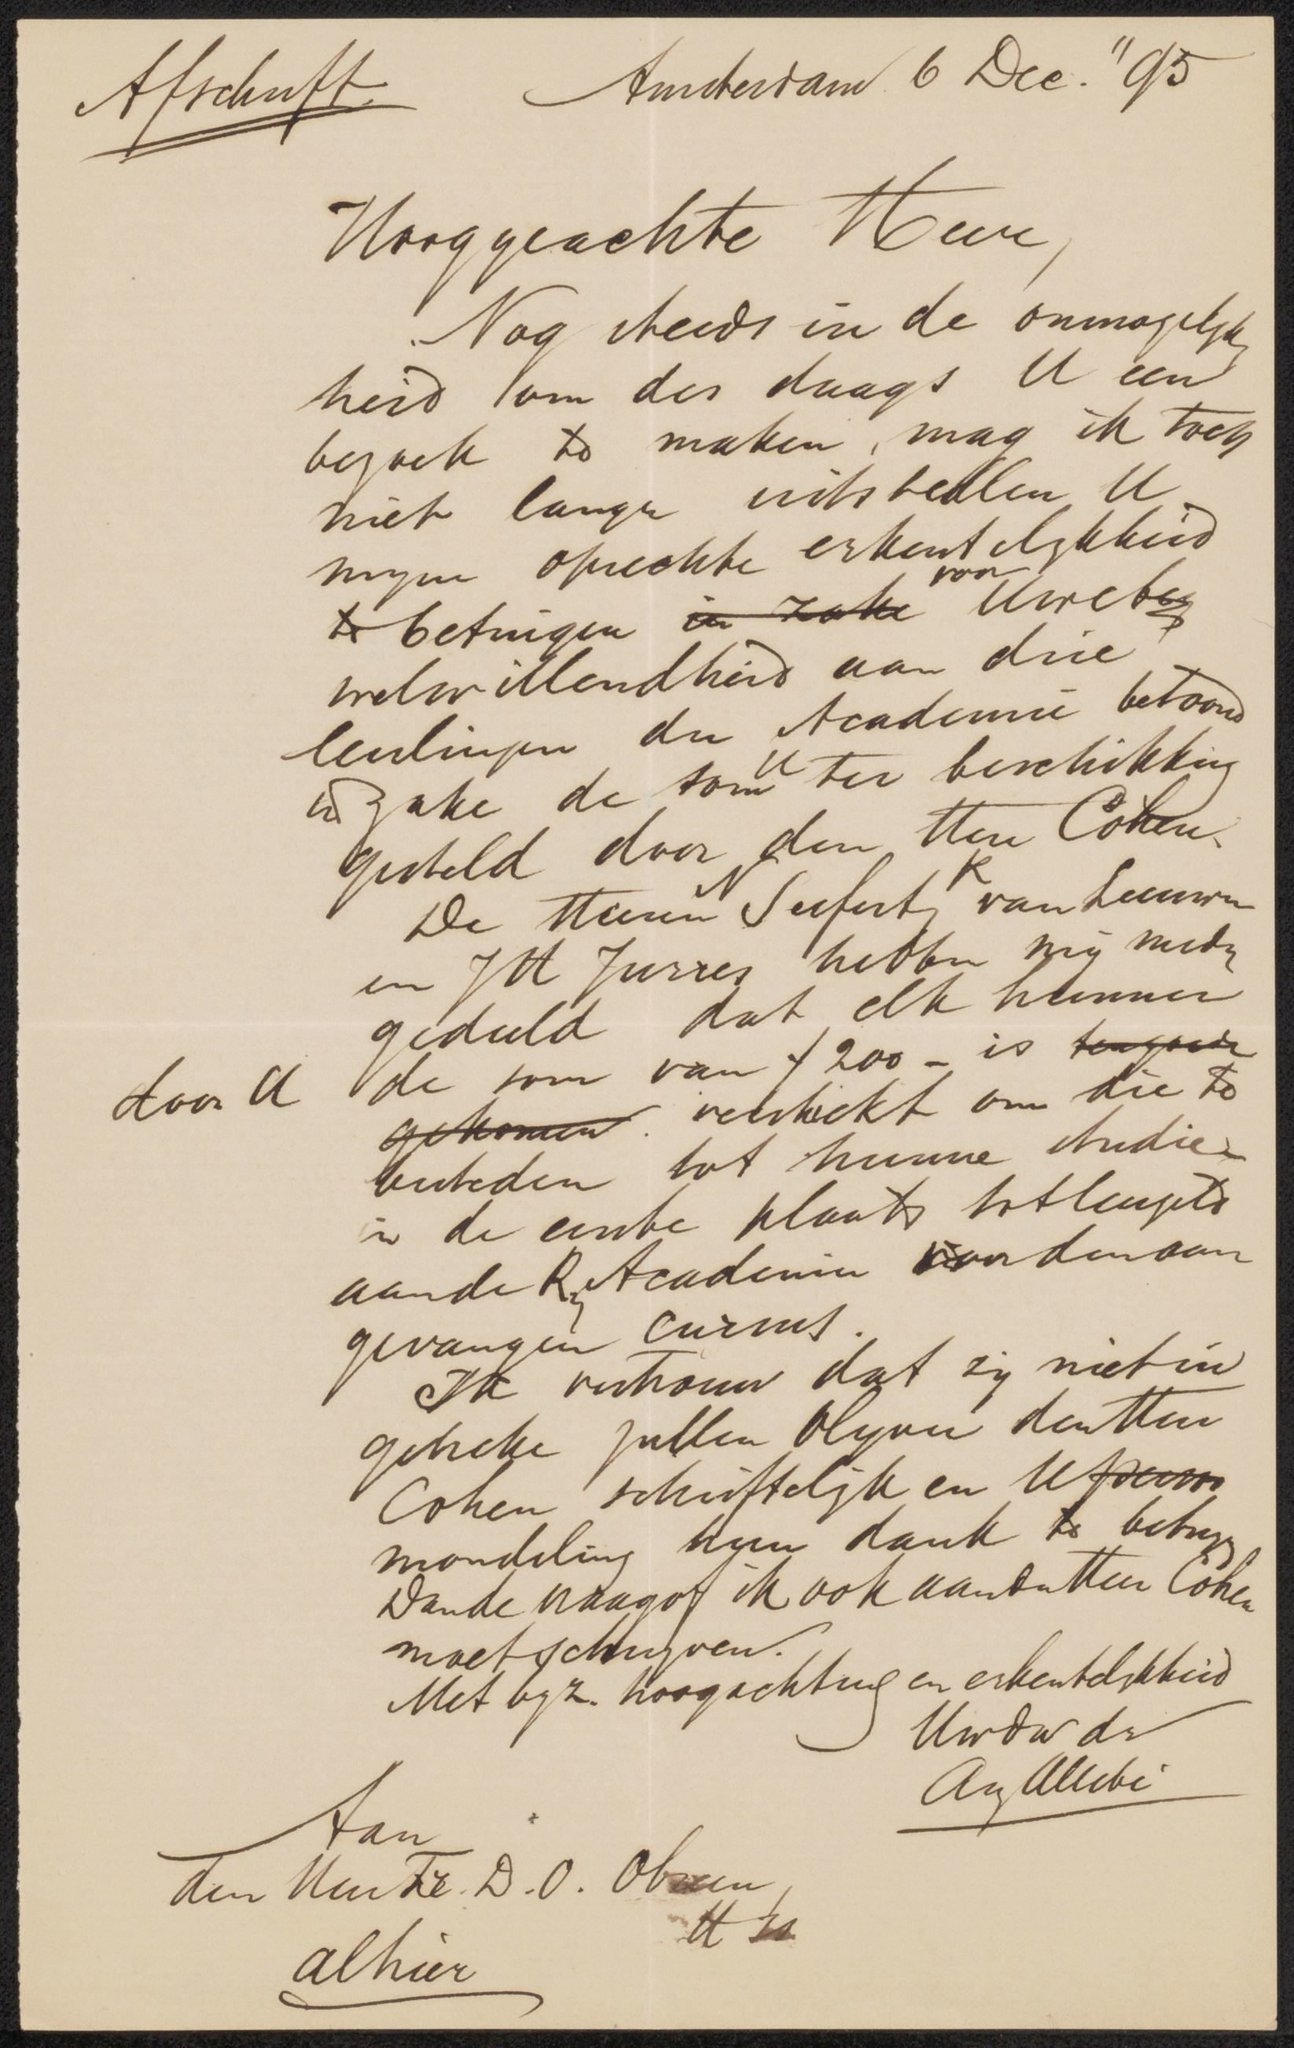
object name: letter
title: Brief aan Frederik Daniel Otto Obreen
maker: august allebé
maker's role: draughtsman, print maker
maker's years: 1838-1927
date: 1895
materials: ink, paper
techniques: pen, writing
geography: amsterdam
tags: print maker, johannes hendricus jurres, rotterdam, amsterdam, draughtsman, frederik daniel otto obreen, education, tuition of the artist (in general), money